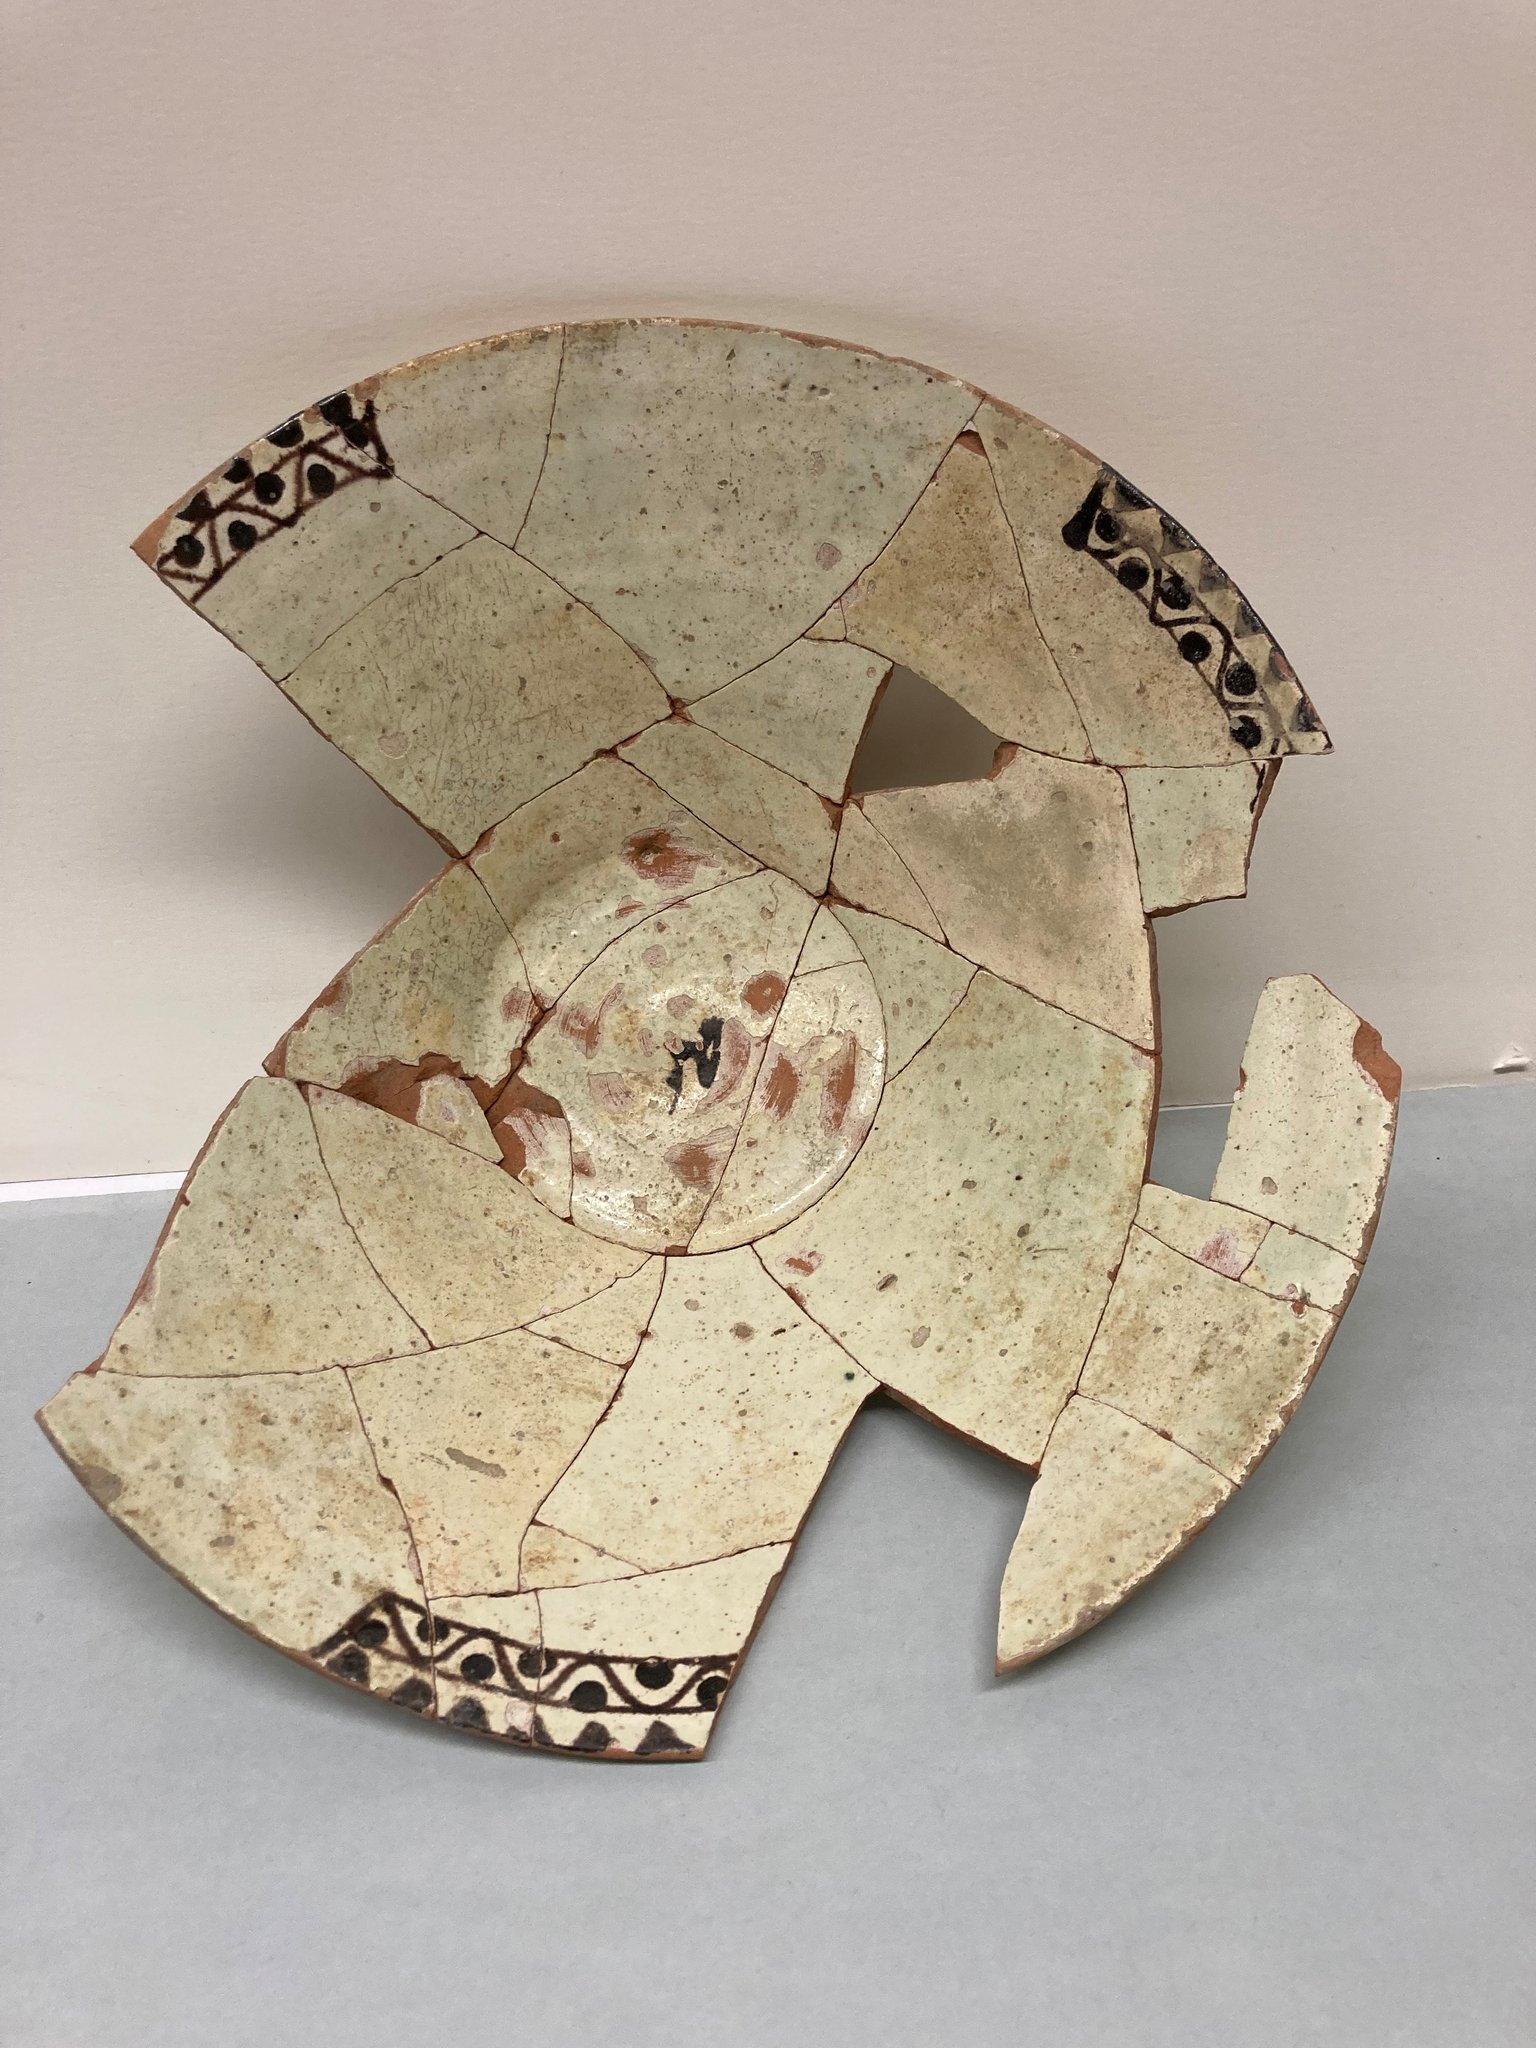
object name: bowl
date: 801-900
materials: earthenware, glaze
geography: iran